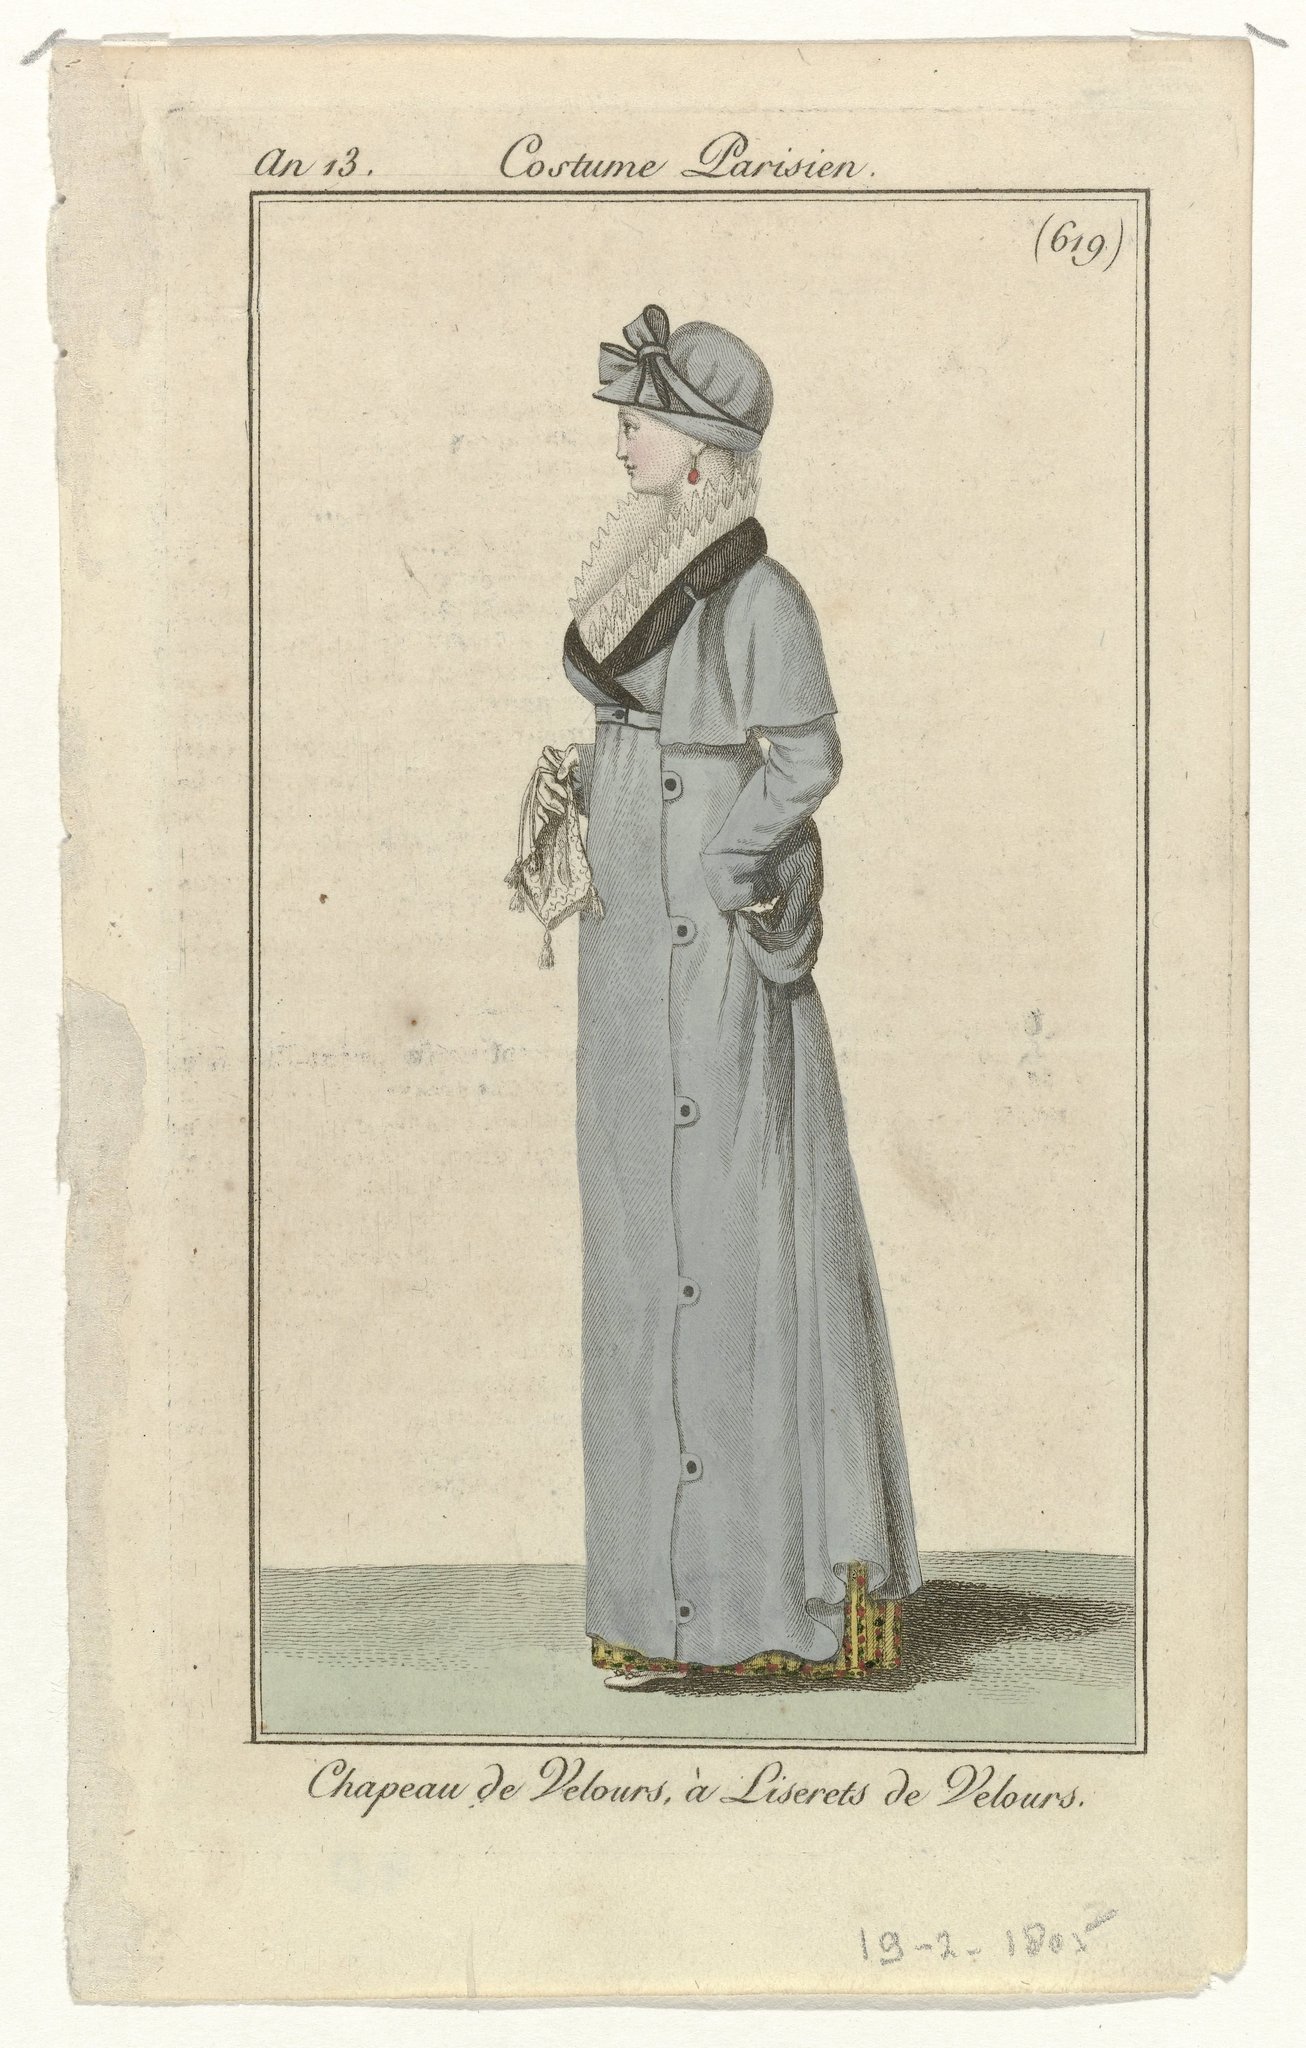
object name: fashion print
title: Journal des Dames et des Modes, Costume Parisien, 19 février 1805, An 13, (619): Chapeau de Velours (...)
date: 1805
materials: paper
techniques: engraving, hand coloring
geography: paris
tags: ear-rings (+ women's clothes), bag (reticule) (+ women's clothes), coat (+ women's clothes), head-gear (+ women's clothes), fashion plates, shoes, sandals (+ women's clothes), dress, gown (+ women's clothes)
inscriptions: caption: ‘Chapeau de Velours, à Liserets de Velours.’, title: ‘Costume Parisien.’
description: Staande vrouw naar links met op het hoofd een hoed van fluweel met een donkere bies van fluweel. Zij draagt een mantel met overslag. Donkere revers, schouderkraag. Opstaande gekartelde kraag bestaande uit twee lagen. Oorbellen, een reticule in de hand. De prent maakt deel uit van het modetijdschrift Journal des Dames et des Modes, uitgegeven door Pierre de la Mésangère, Parijs, 1797-1839.